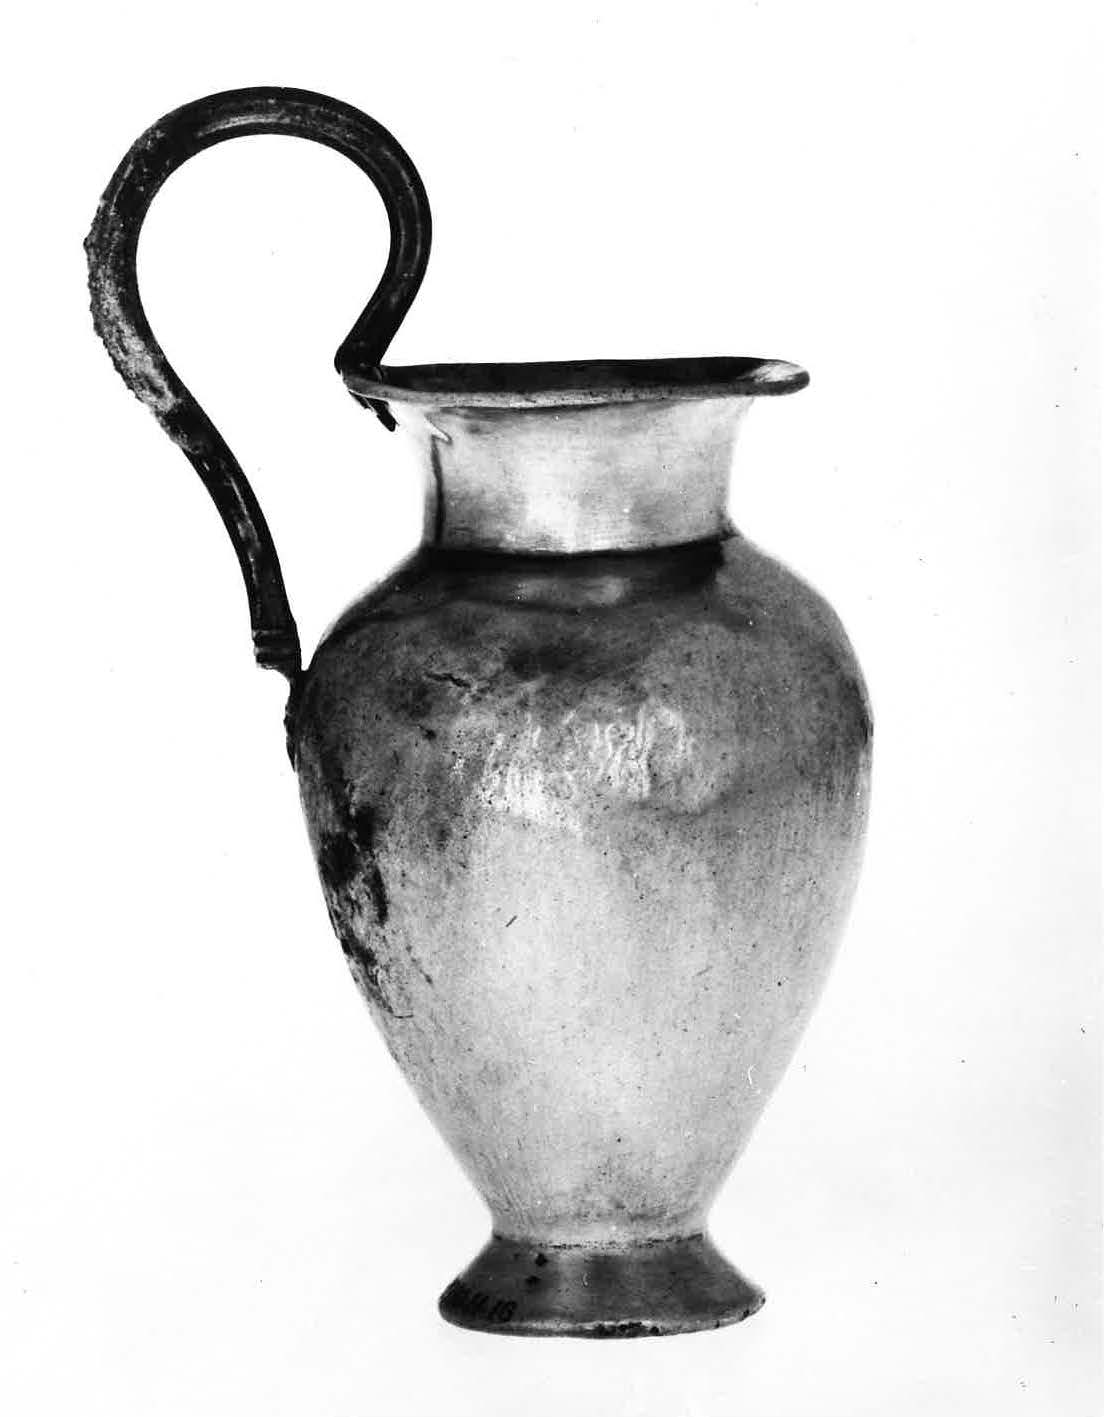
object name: oinochoe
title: Silver oinochoe (pitcher)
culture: east greek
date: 600-501 BCE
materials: silver